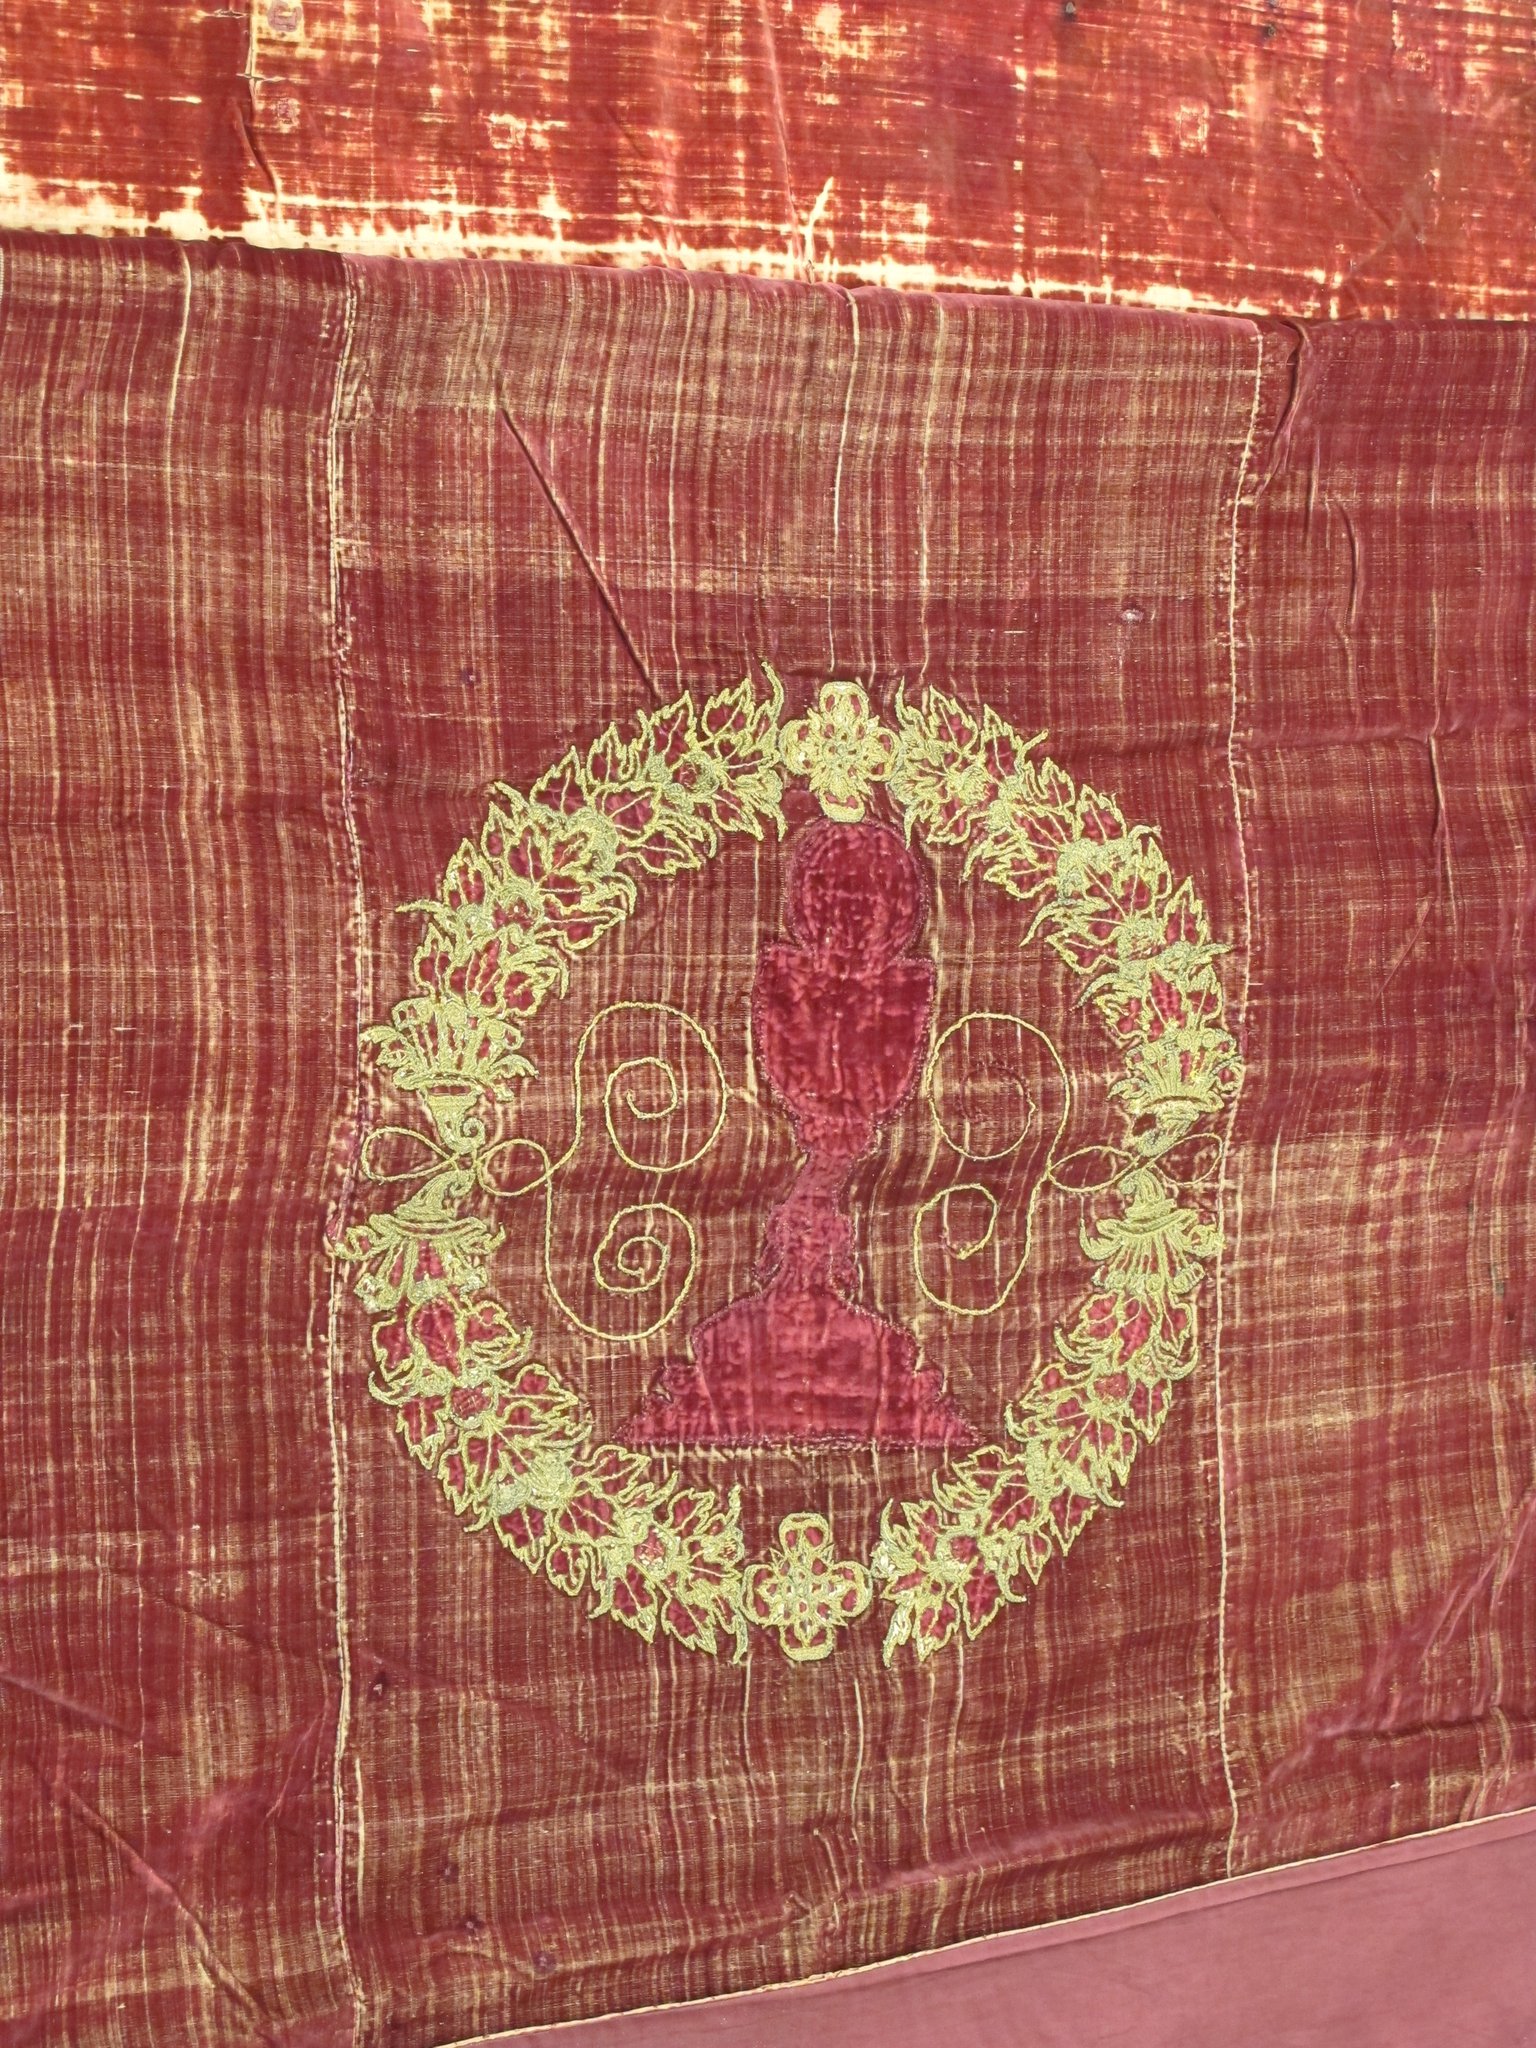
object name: textile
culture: european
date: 1401-1500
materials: velvet